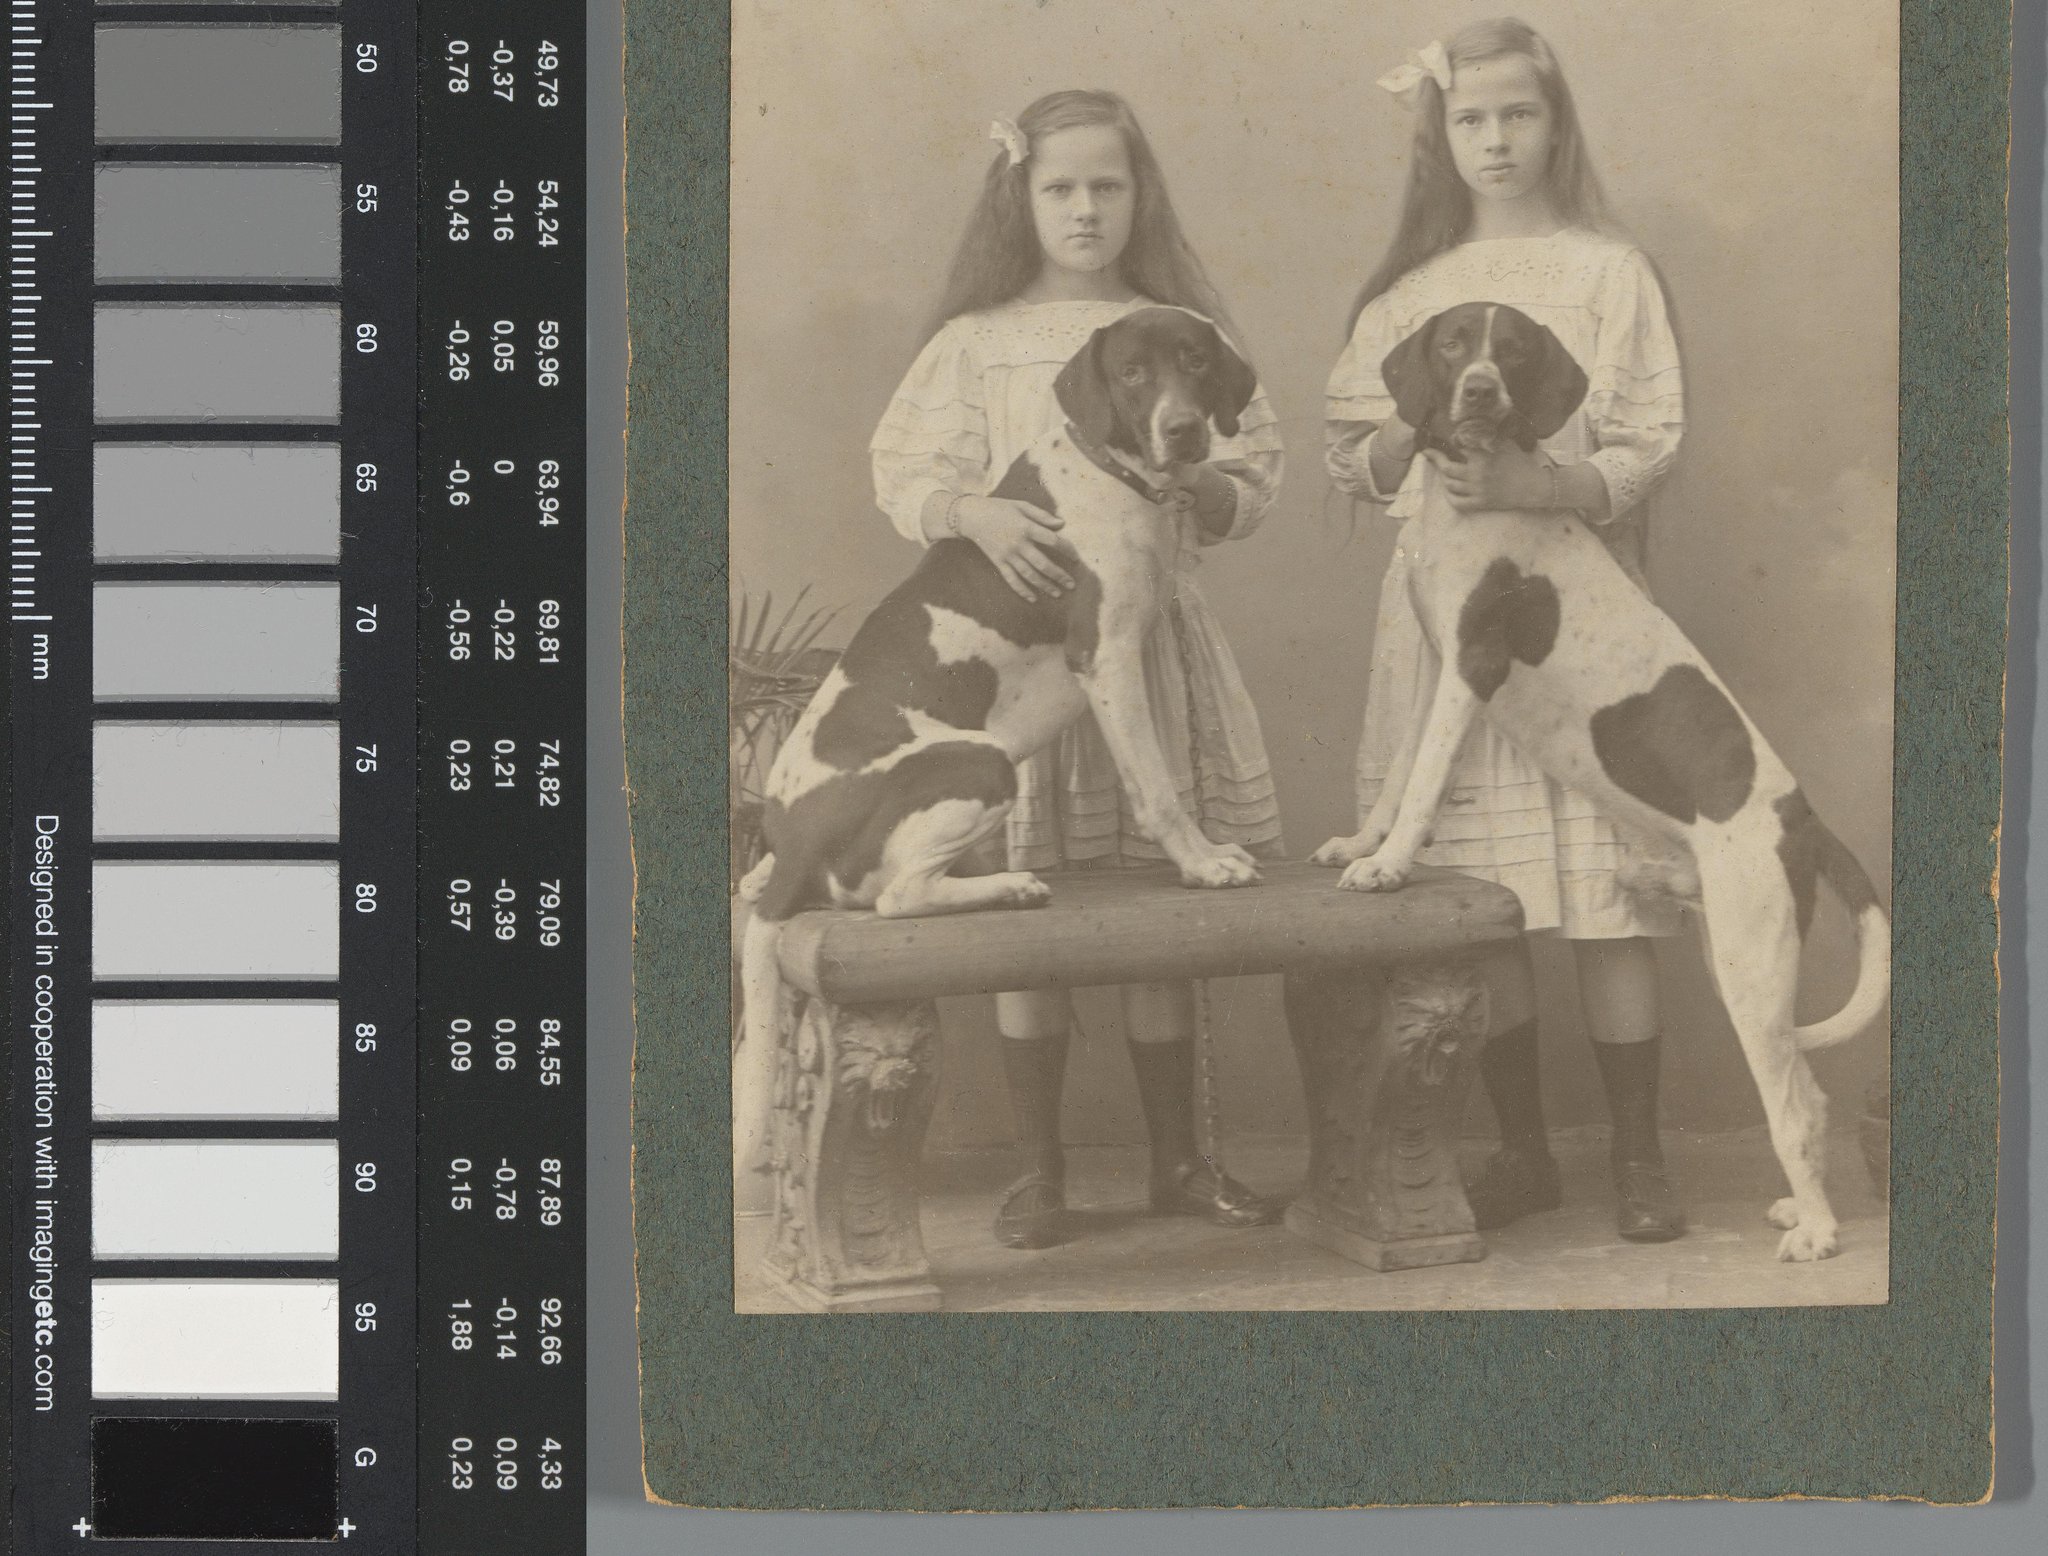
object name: photograph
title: Studioportret van Loentje en Willy Onnen met twee honden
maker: Anonymous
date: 1900-1910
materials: cardboard, photographic support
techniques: albumen print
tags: amsterdam, carolina frederika onnen (lien/loen)